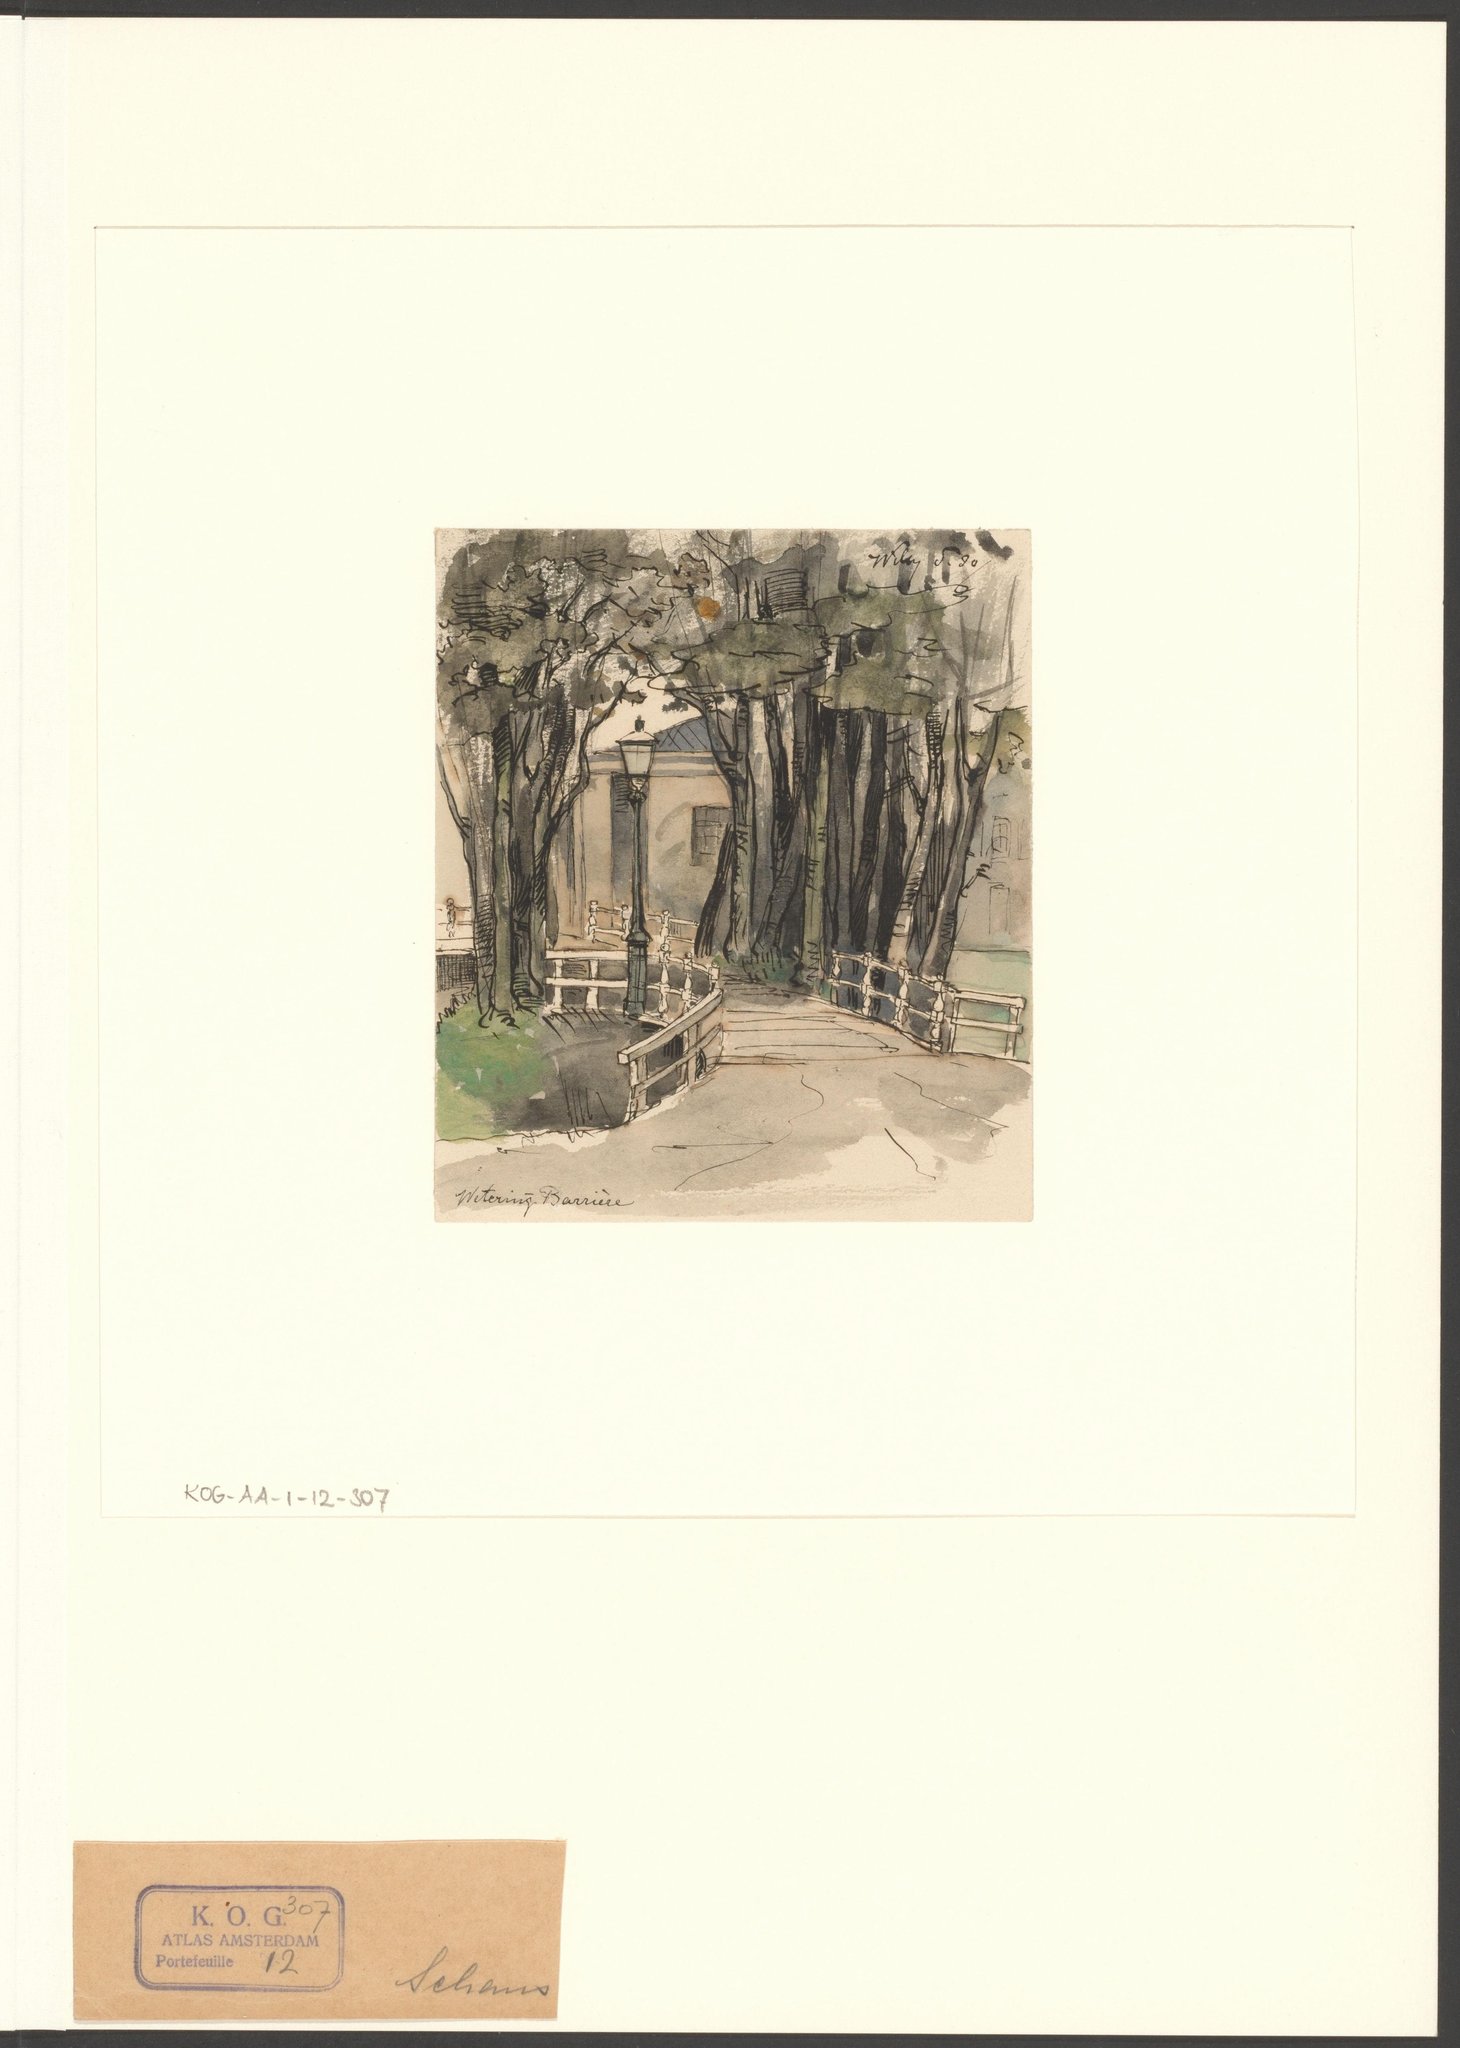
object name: drawing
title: Gezicht op het Polderhuis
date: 1880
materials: ink, paper, watercolor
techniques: brush, pen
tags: city-view in general; 'veduta', canal, inn, coffee-house, public house, etc., bridge in city across river, canal, etc.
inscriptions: inscription: ‘Port. 12-307’, signature, date and inscription: ‘Wilm S. 80 / Wetering Barrière’, collector's mark: ‘12’ Lugt 1641b, inscription: ‘de Wetering barrière gezien van de / Buitensingel’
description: Onderwerpsrubriek binnen de Atlas Amsterdam: Sarphatistraat, Schans.